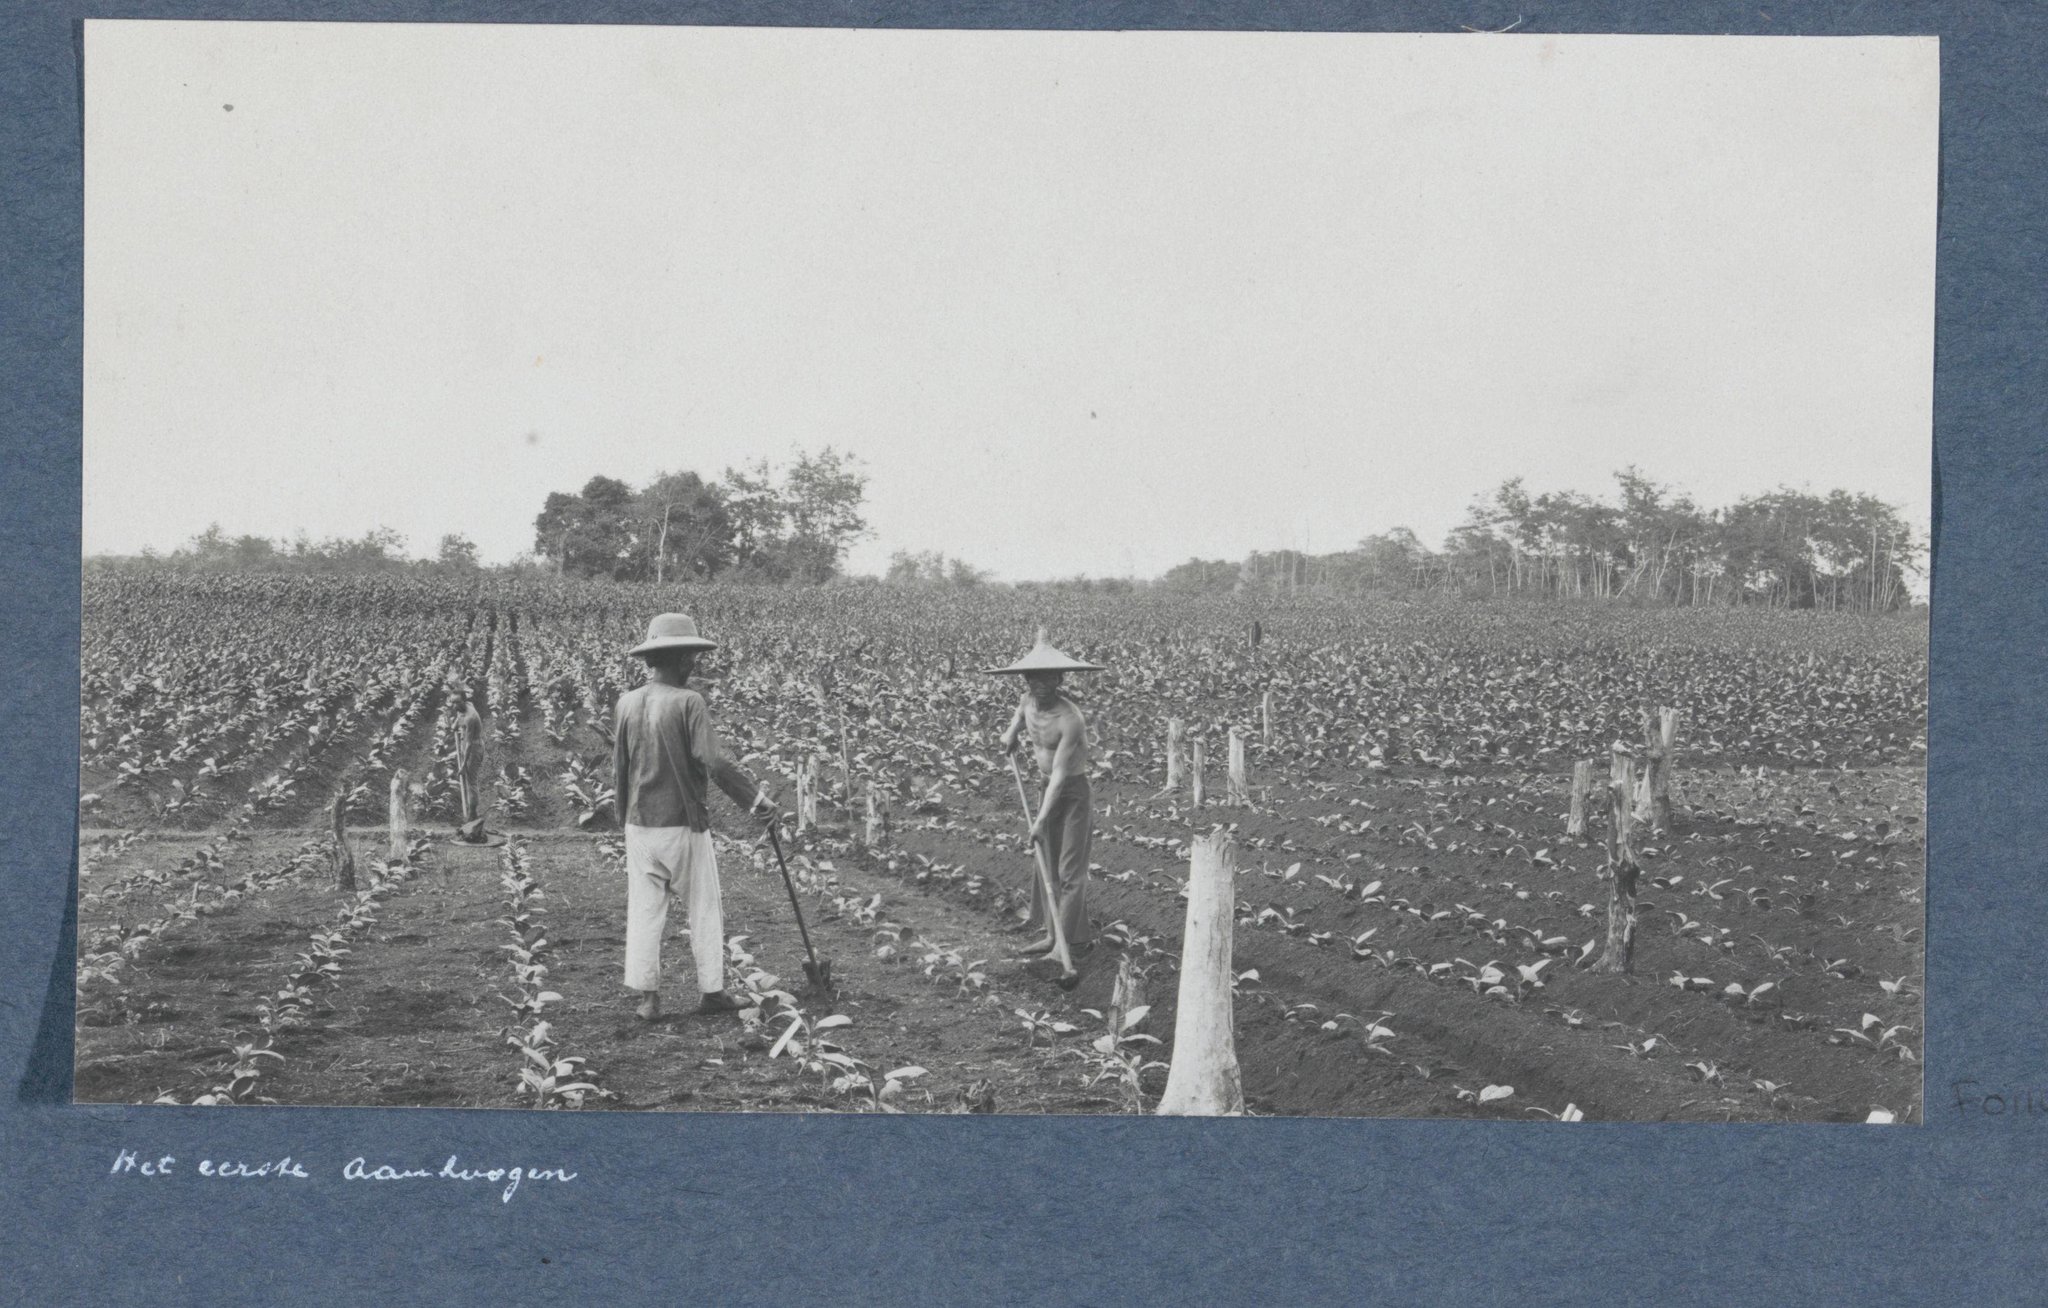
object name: album leaf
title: Mannen bezig met het uitplanten van kiemplanten (bibit) op Sumatra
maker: carl j. kleingrothe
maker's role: fotograaf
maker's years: 1864-1925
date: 1900-1915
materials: paper, photographic support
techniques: gelatin silver print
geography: sumatra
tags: plantation, working class, labourers, tobacco, sumatra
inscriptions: name: ‘Kleingrothe O.K.v.Sumatra’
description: Mogelijk gaat het om contractarbeiders. Onderdeel van reisalbum met foto's van bedrijvigheid en bezienswaardigheden op Sumatra en Java en van de reis naar en van Nederlands-Indië.